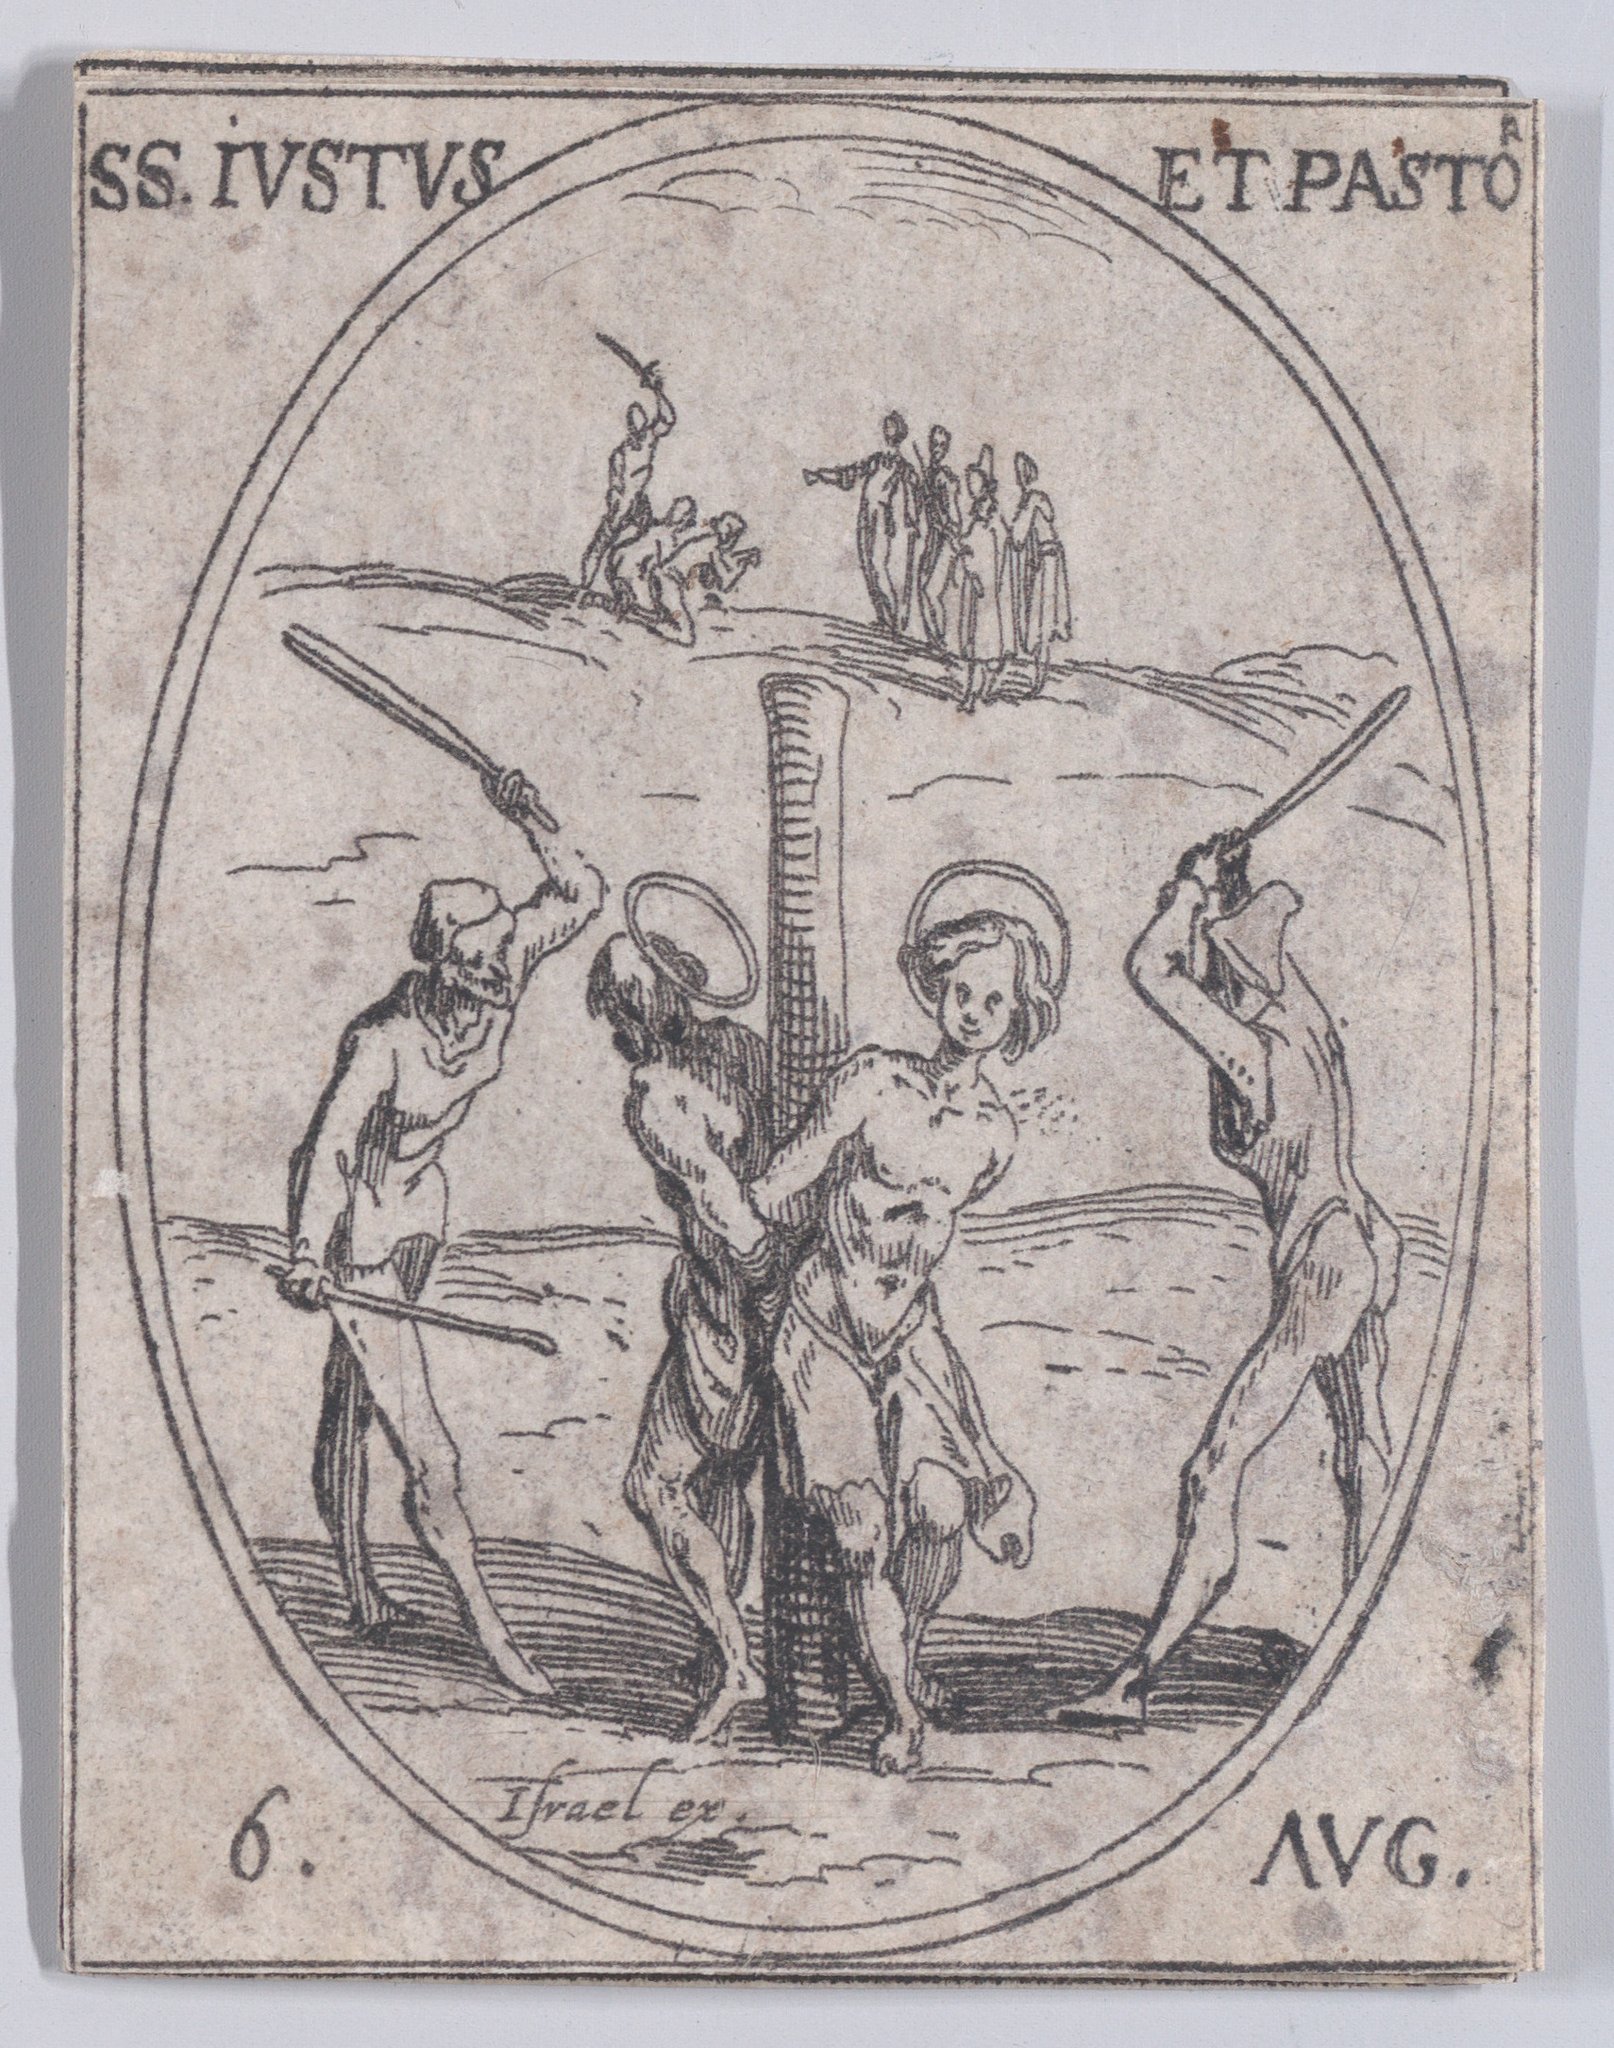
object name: print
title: S. Juste et S. Pastor (St. Justus and St. Pastor), August 6th, from "Les Images De Tous Les Saincts et Saintes de L'Année" (Images of All of the Saints and Religious Events of the Year)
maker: jacques callot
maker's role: artist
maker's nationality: french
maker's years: 1592-1635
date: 1636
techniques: etching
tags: men,saints